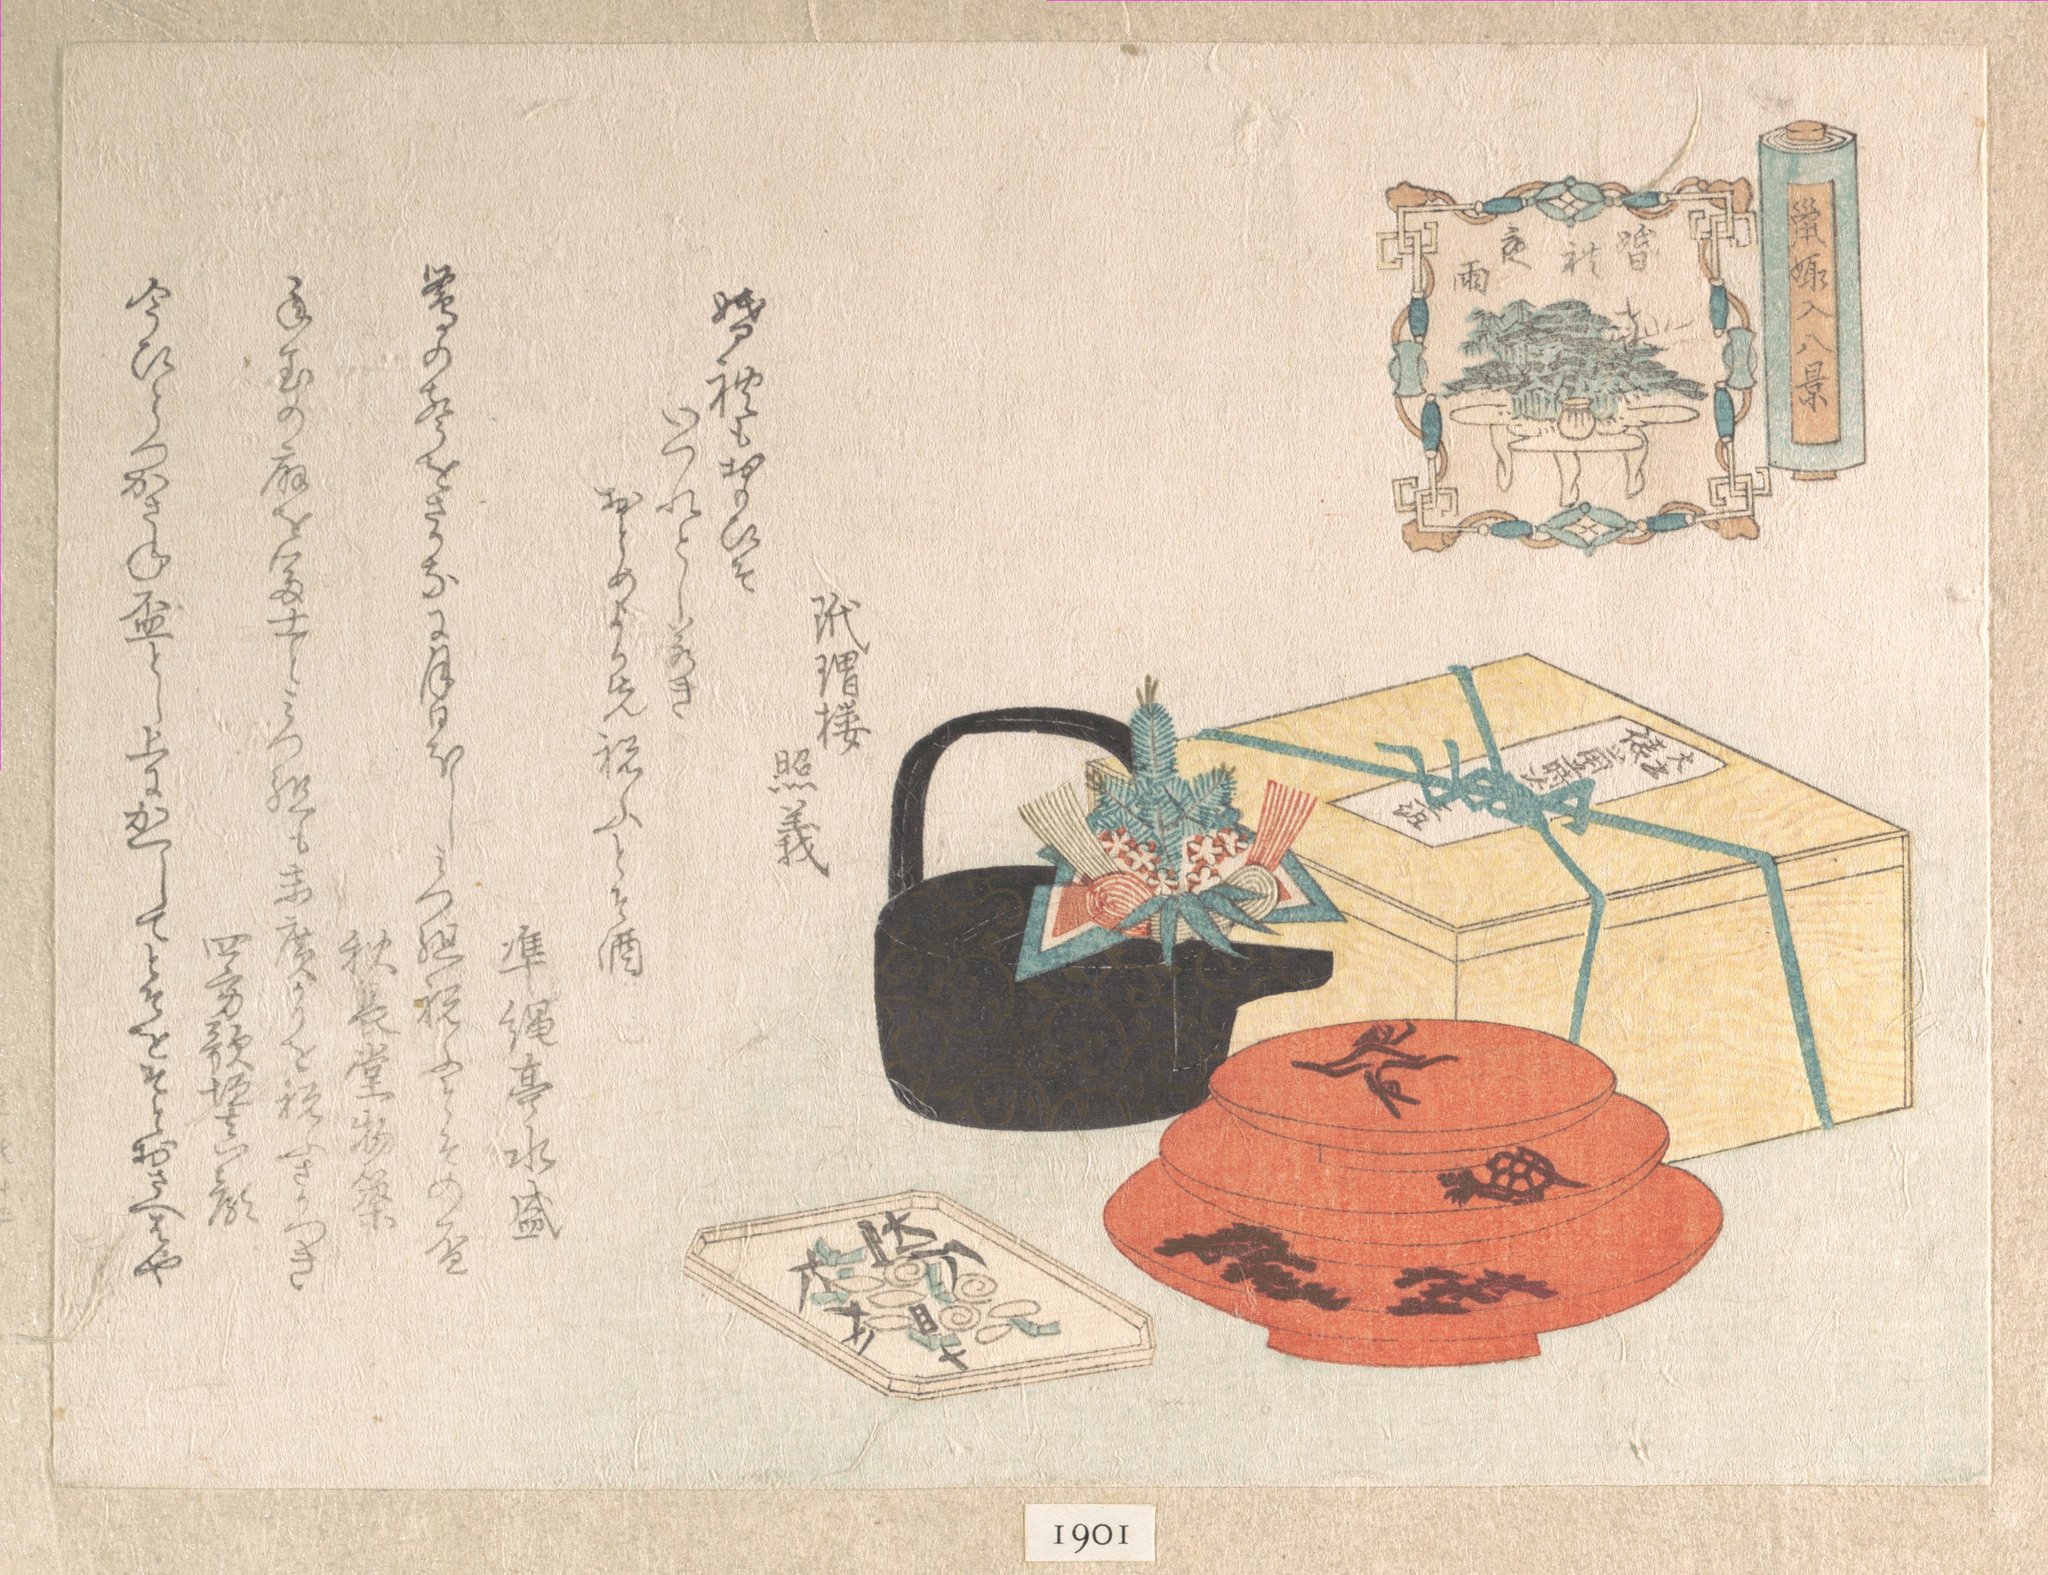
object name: print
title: Still Life; Design of Yogoyomi; Pictorial Calendar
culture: japanese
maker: unidentified artist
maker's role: artist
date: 1816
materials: ink, paper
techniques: surimono, woodblock print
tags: still life,calendars